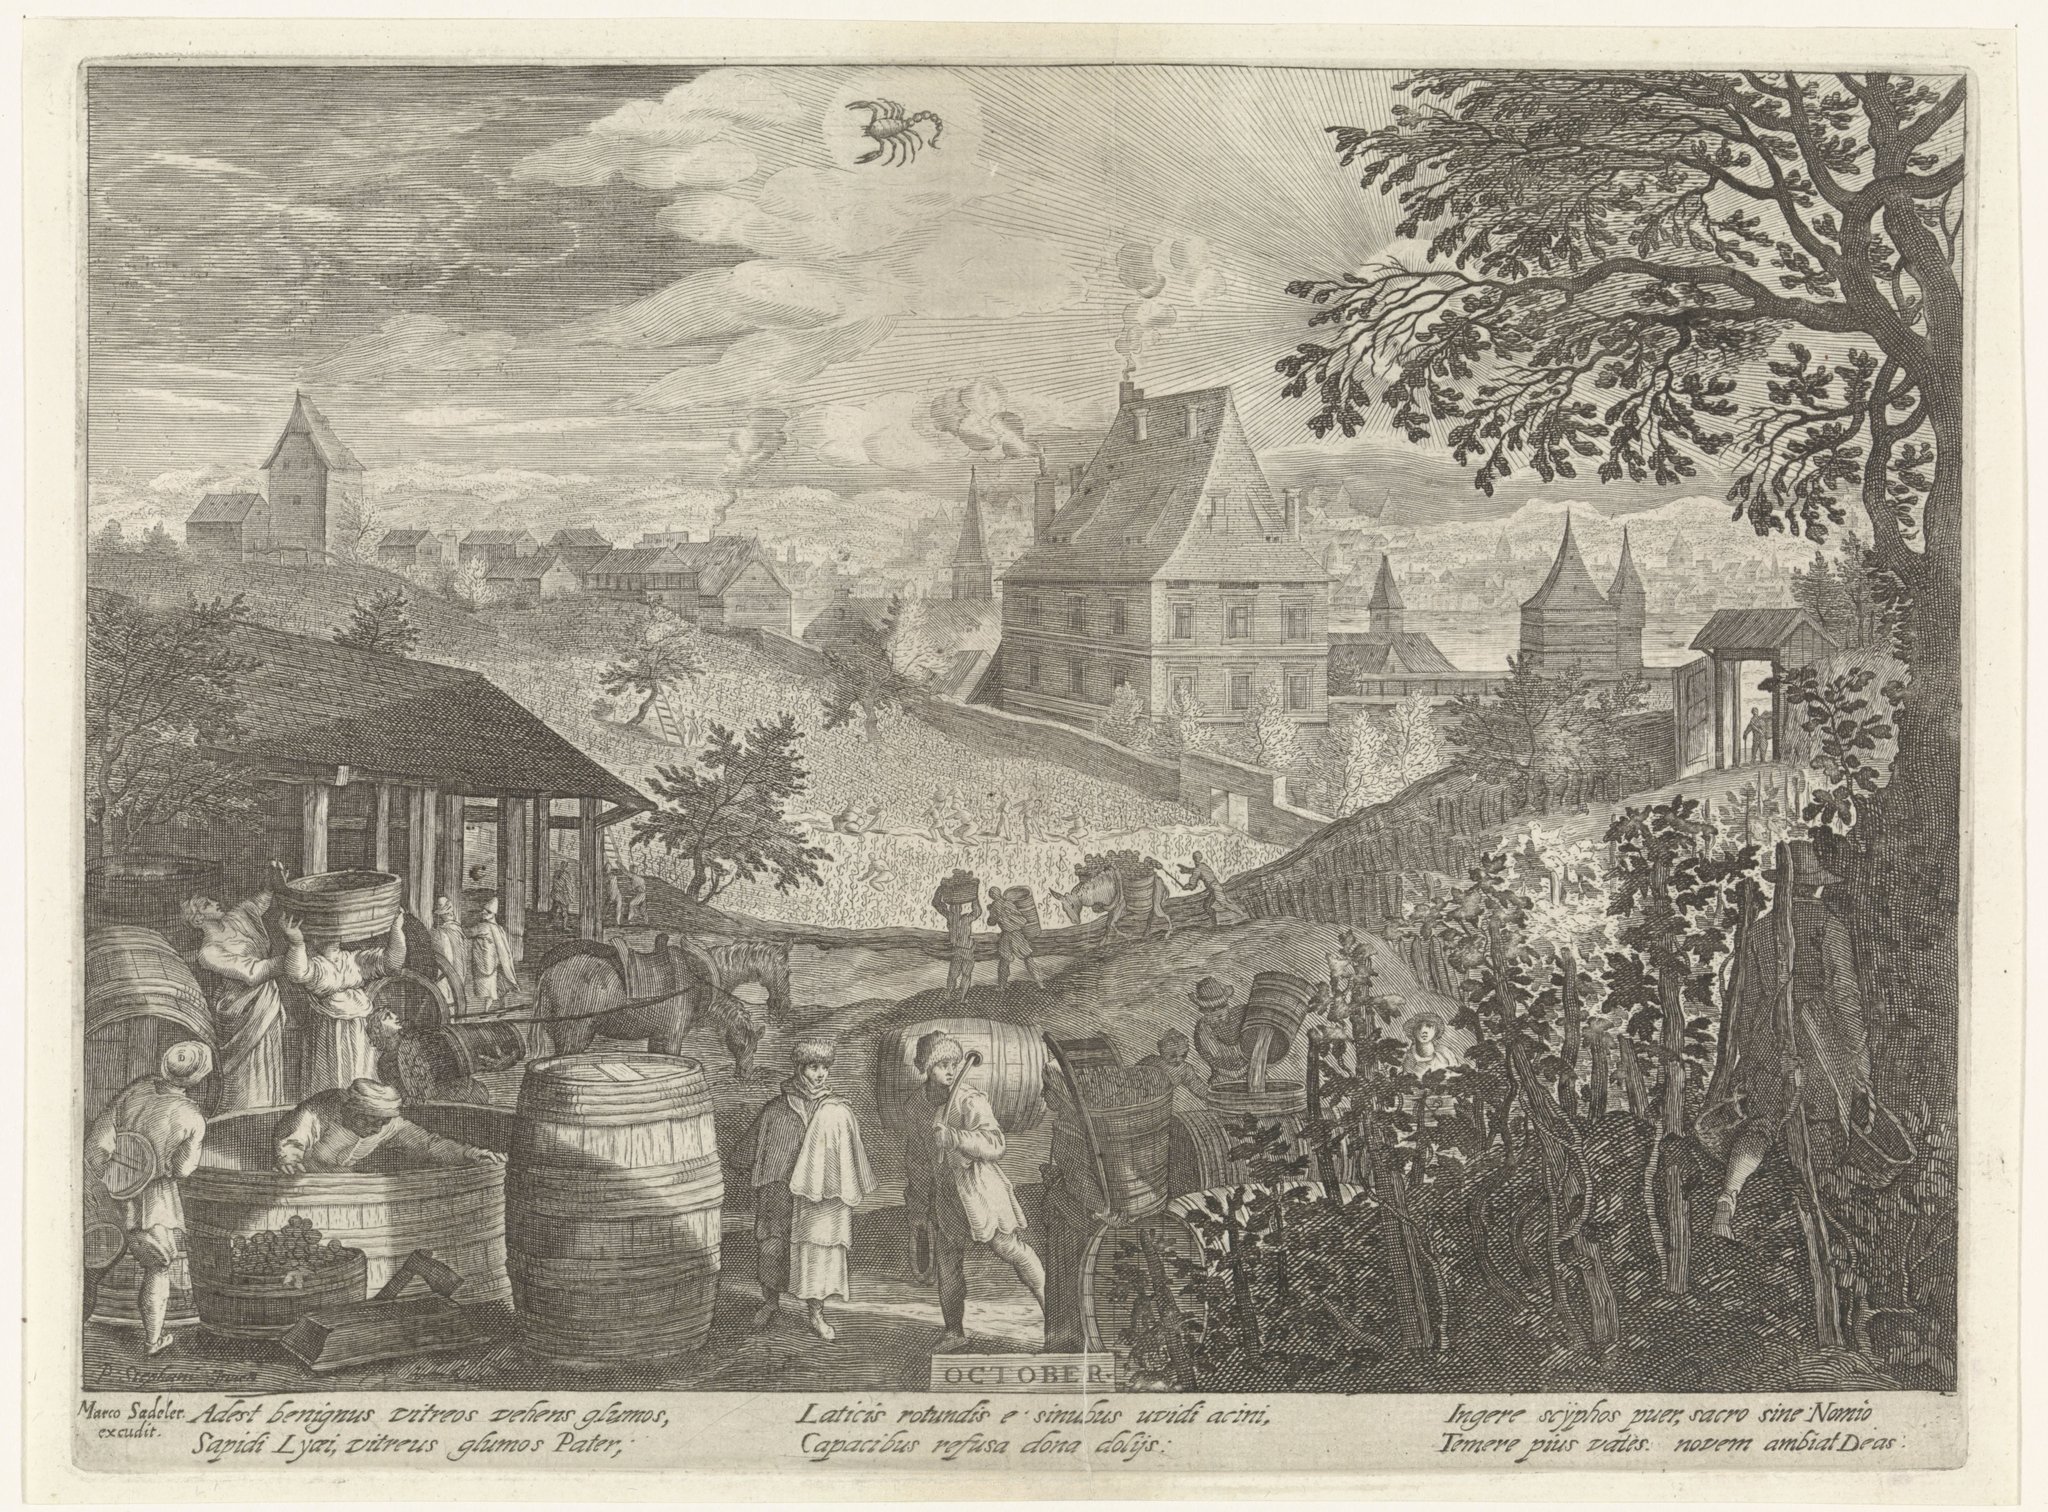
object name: print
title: De twaalf maanden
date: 1607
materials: paper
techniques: engraving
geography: prague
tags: treading grapes, vintage, grape harvest, transport of grapes, october and its 'labours' (+ with zodiacal signs)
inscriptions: collector's mark: Lugt 240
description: Oktober is de wijnmaand. Centraal staat de druivenpluk en het maken en tonnen van wijn. Mannen, vrouwen en kinderen plukken druiven. Linksvoor worden ze geperst. Middenboven het sterrenbeeld Schorpioen. De prent heeft een Latijns onderschrift.